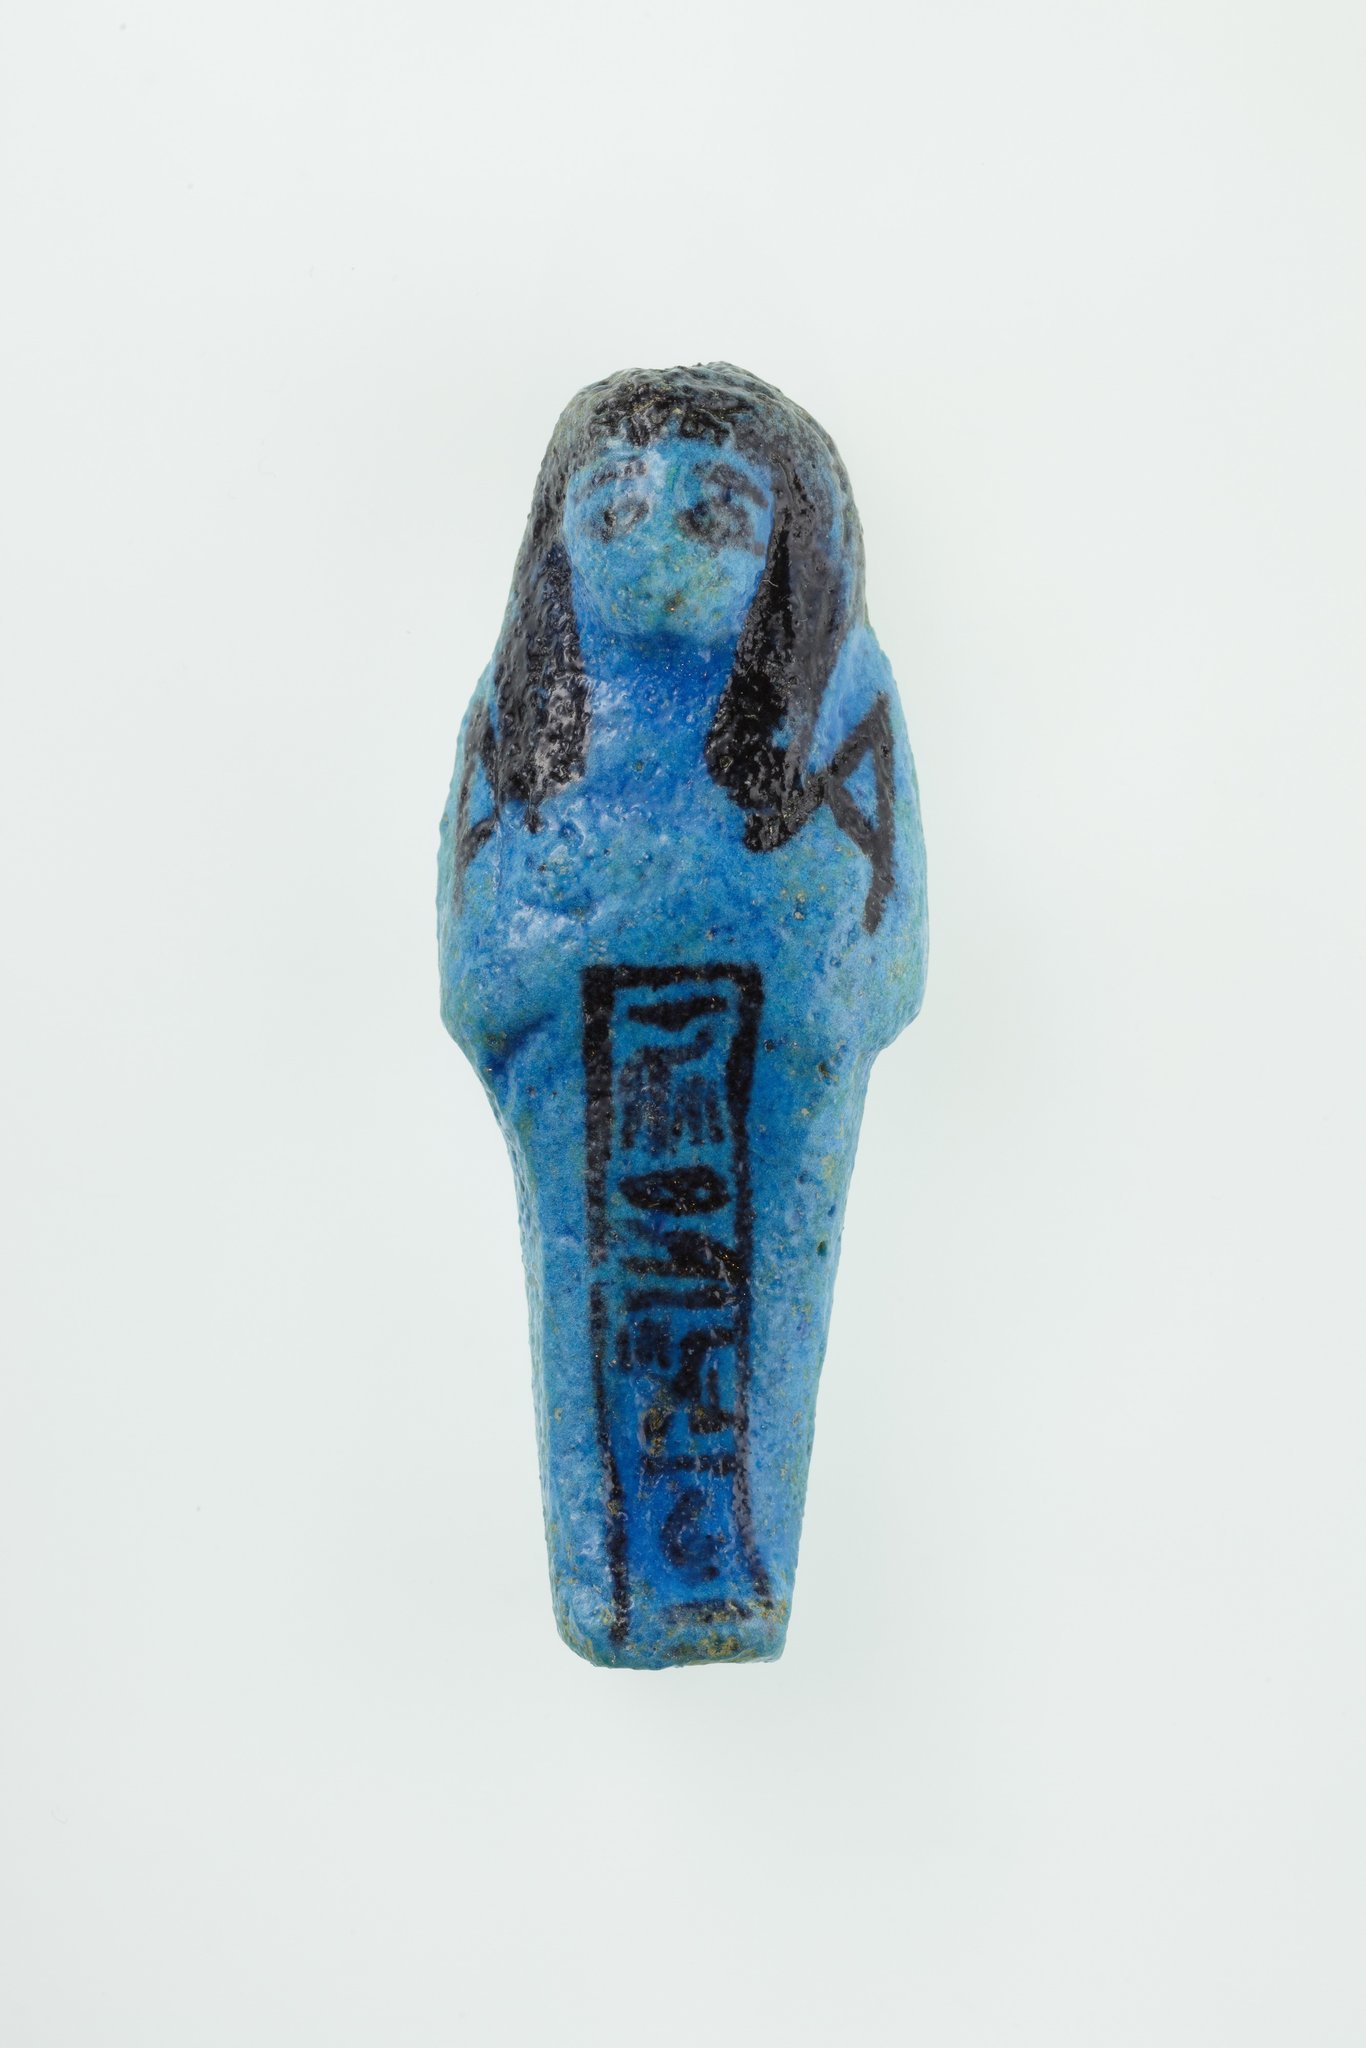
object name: shabti, worker, nauny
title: Worker Shabti of Nauny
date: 1050 BCE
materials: faience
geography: egypt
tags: hieroglyphs